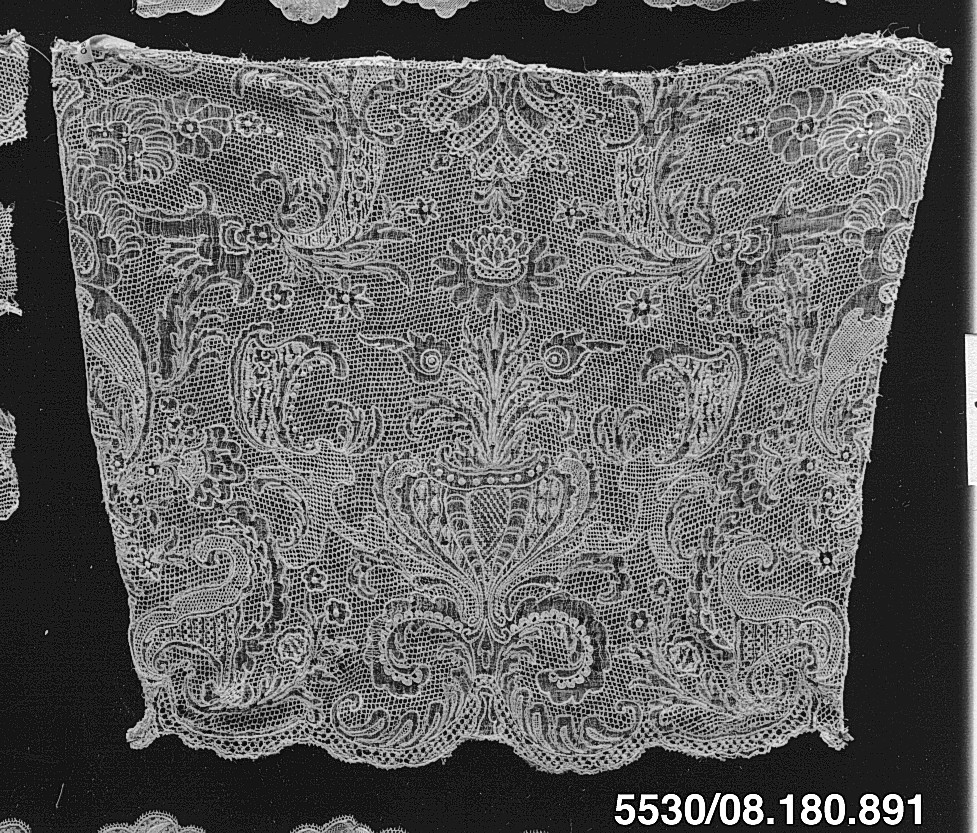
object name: cuff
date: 1701-1800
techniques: embroidery